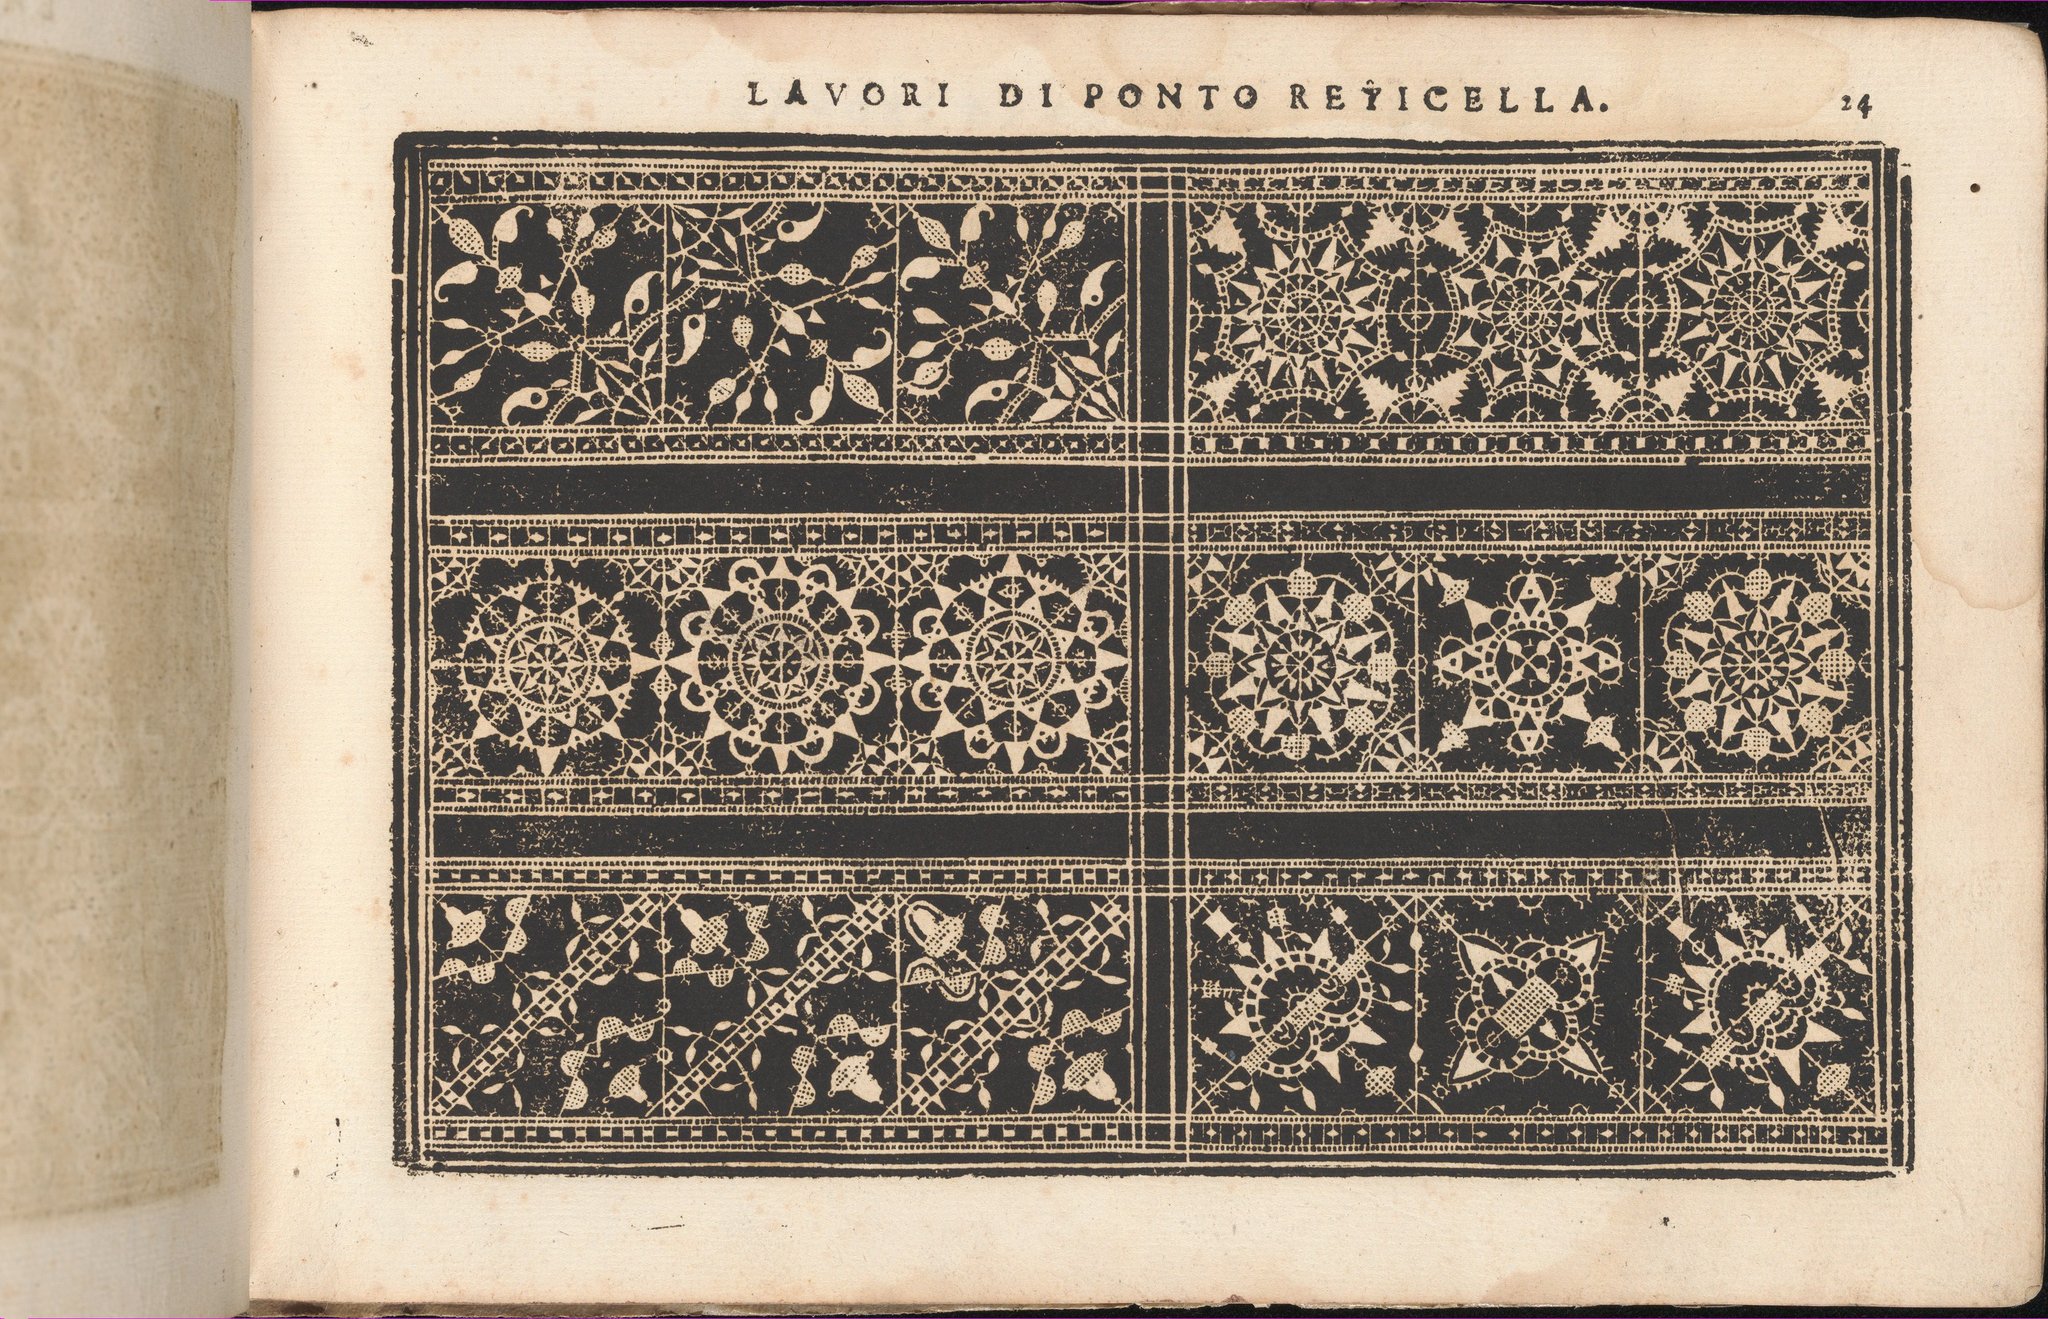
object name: book print ornament architecture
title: Teatro delle Nobili et Virtuose Donne..., page 20 (recto)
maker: isabella catanea parasole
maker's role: author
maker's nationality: italian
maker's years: 1565-1625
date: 1616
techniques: engraving, woodcut